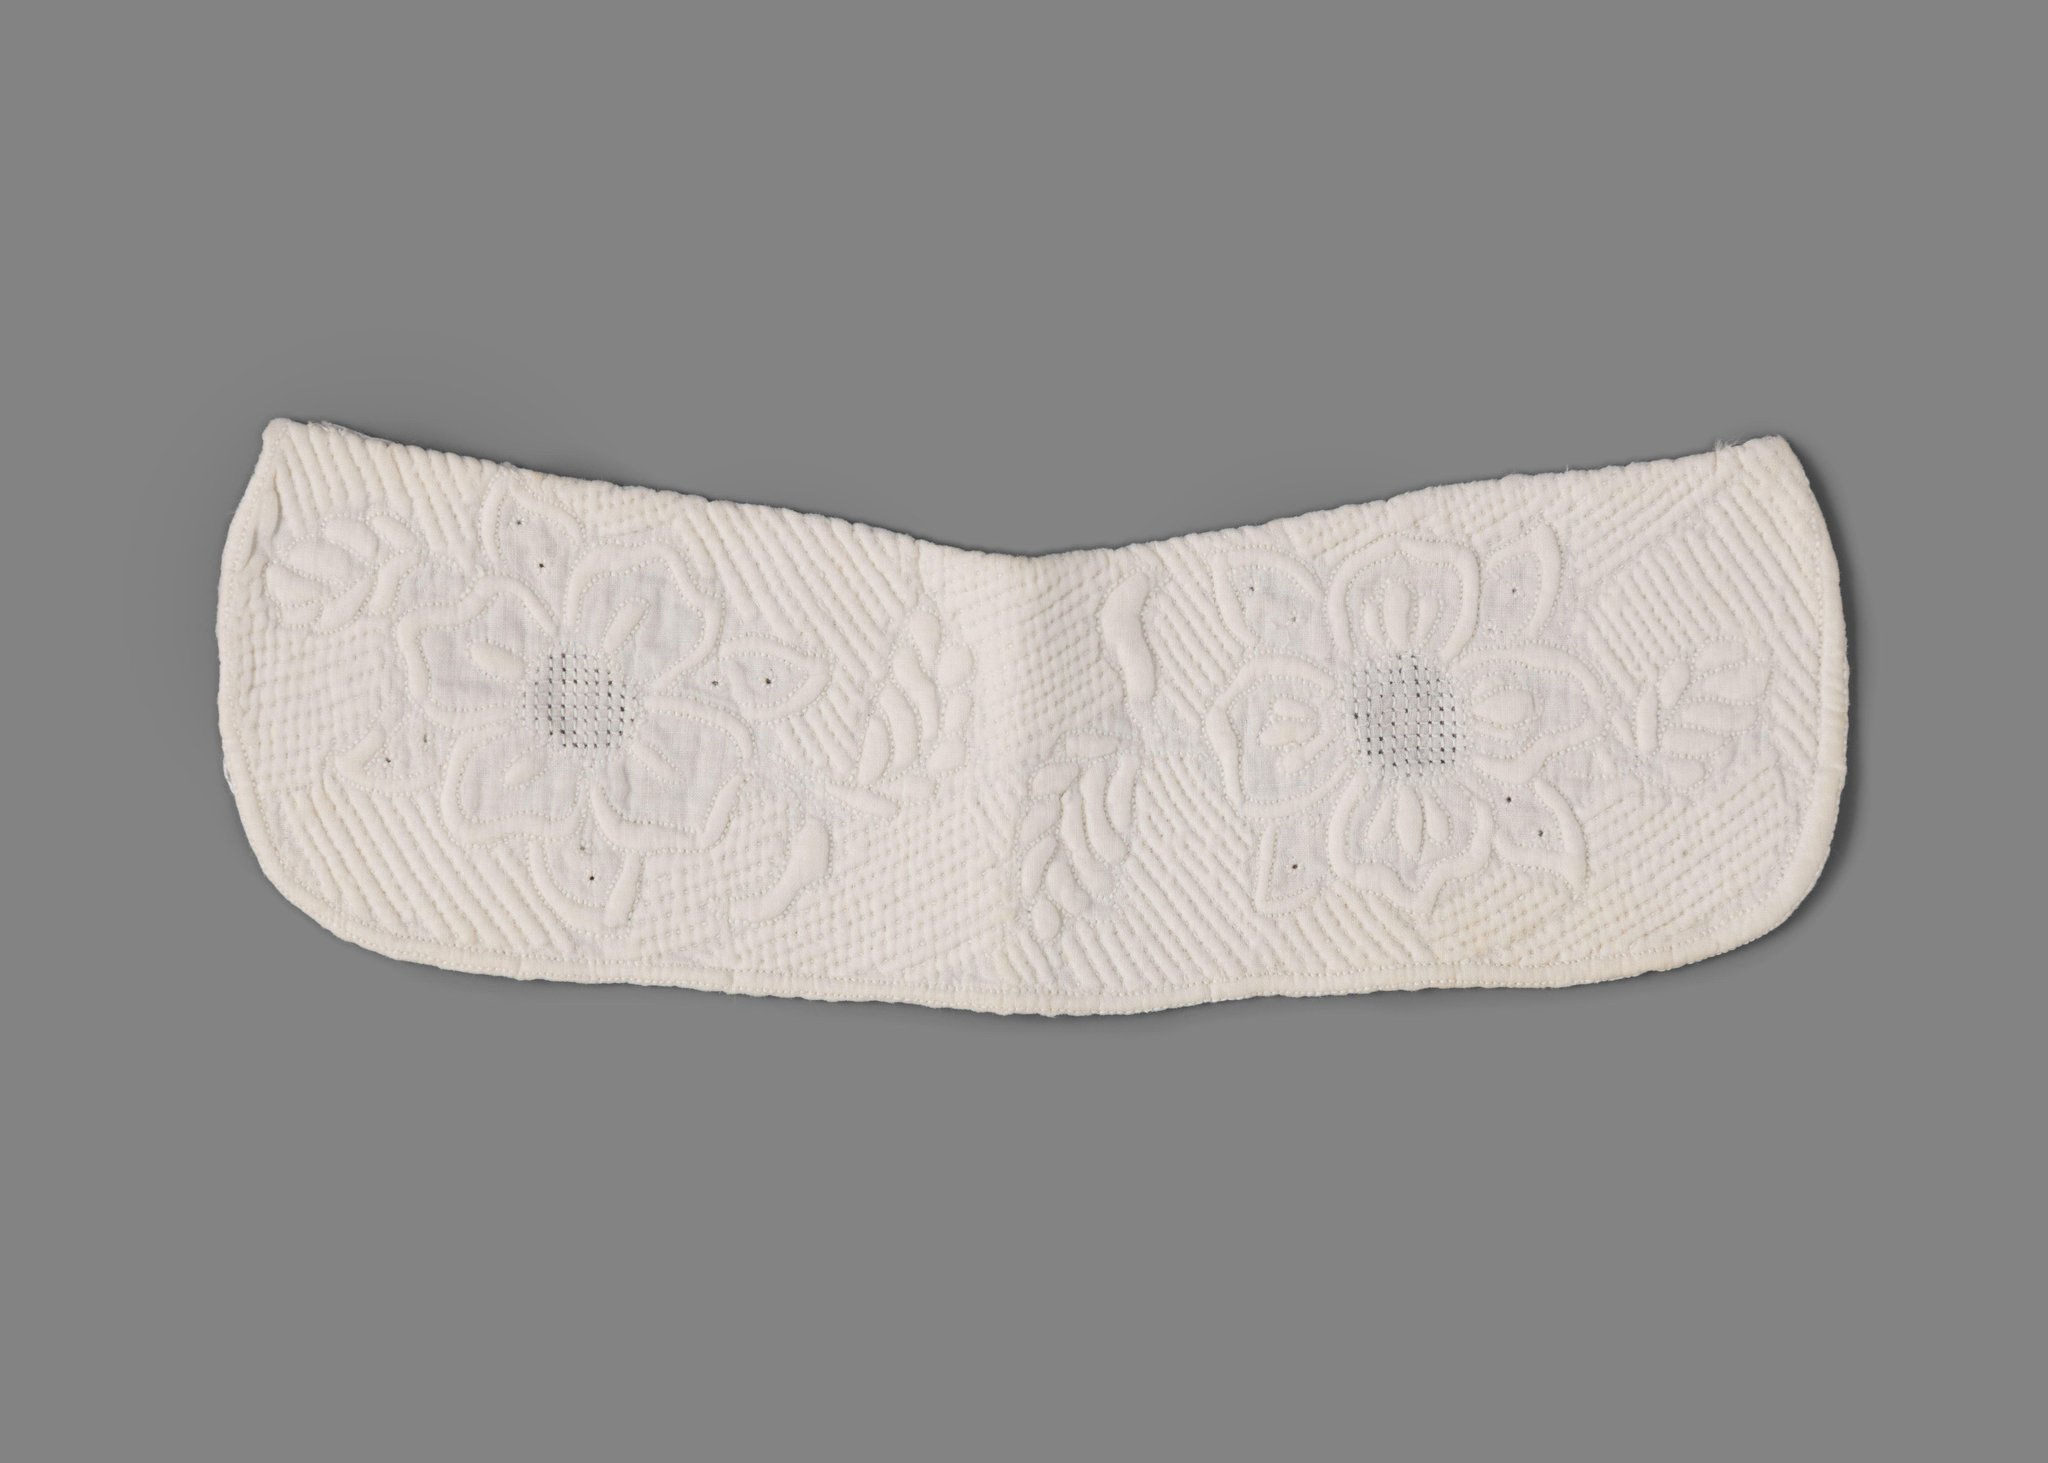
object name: clothing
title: Manchet met doorstikt borduurwerk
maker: Anonymous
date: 1700-1850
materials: linen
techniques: quilted embroidery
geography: netherlands